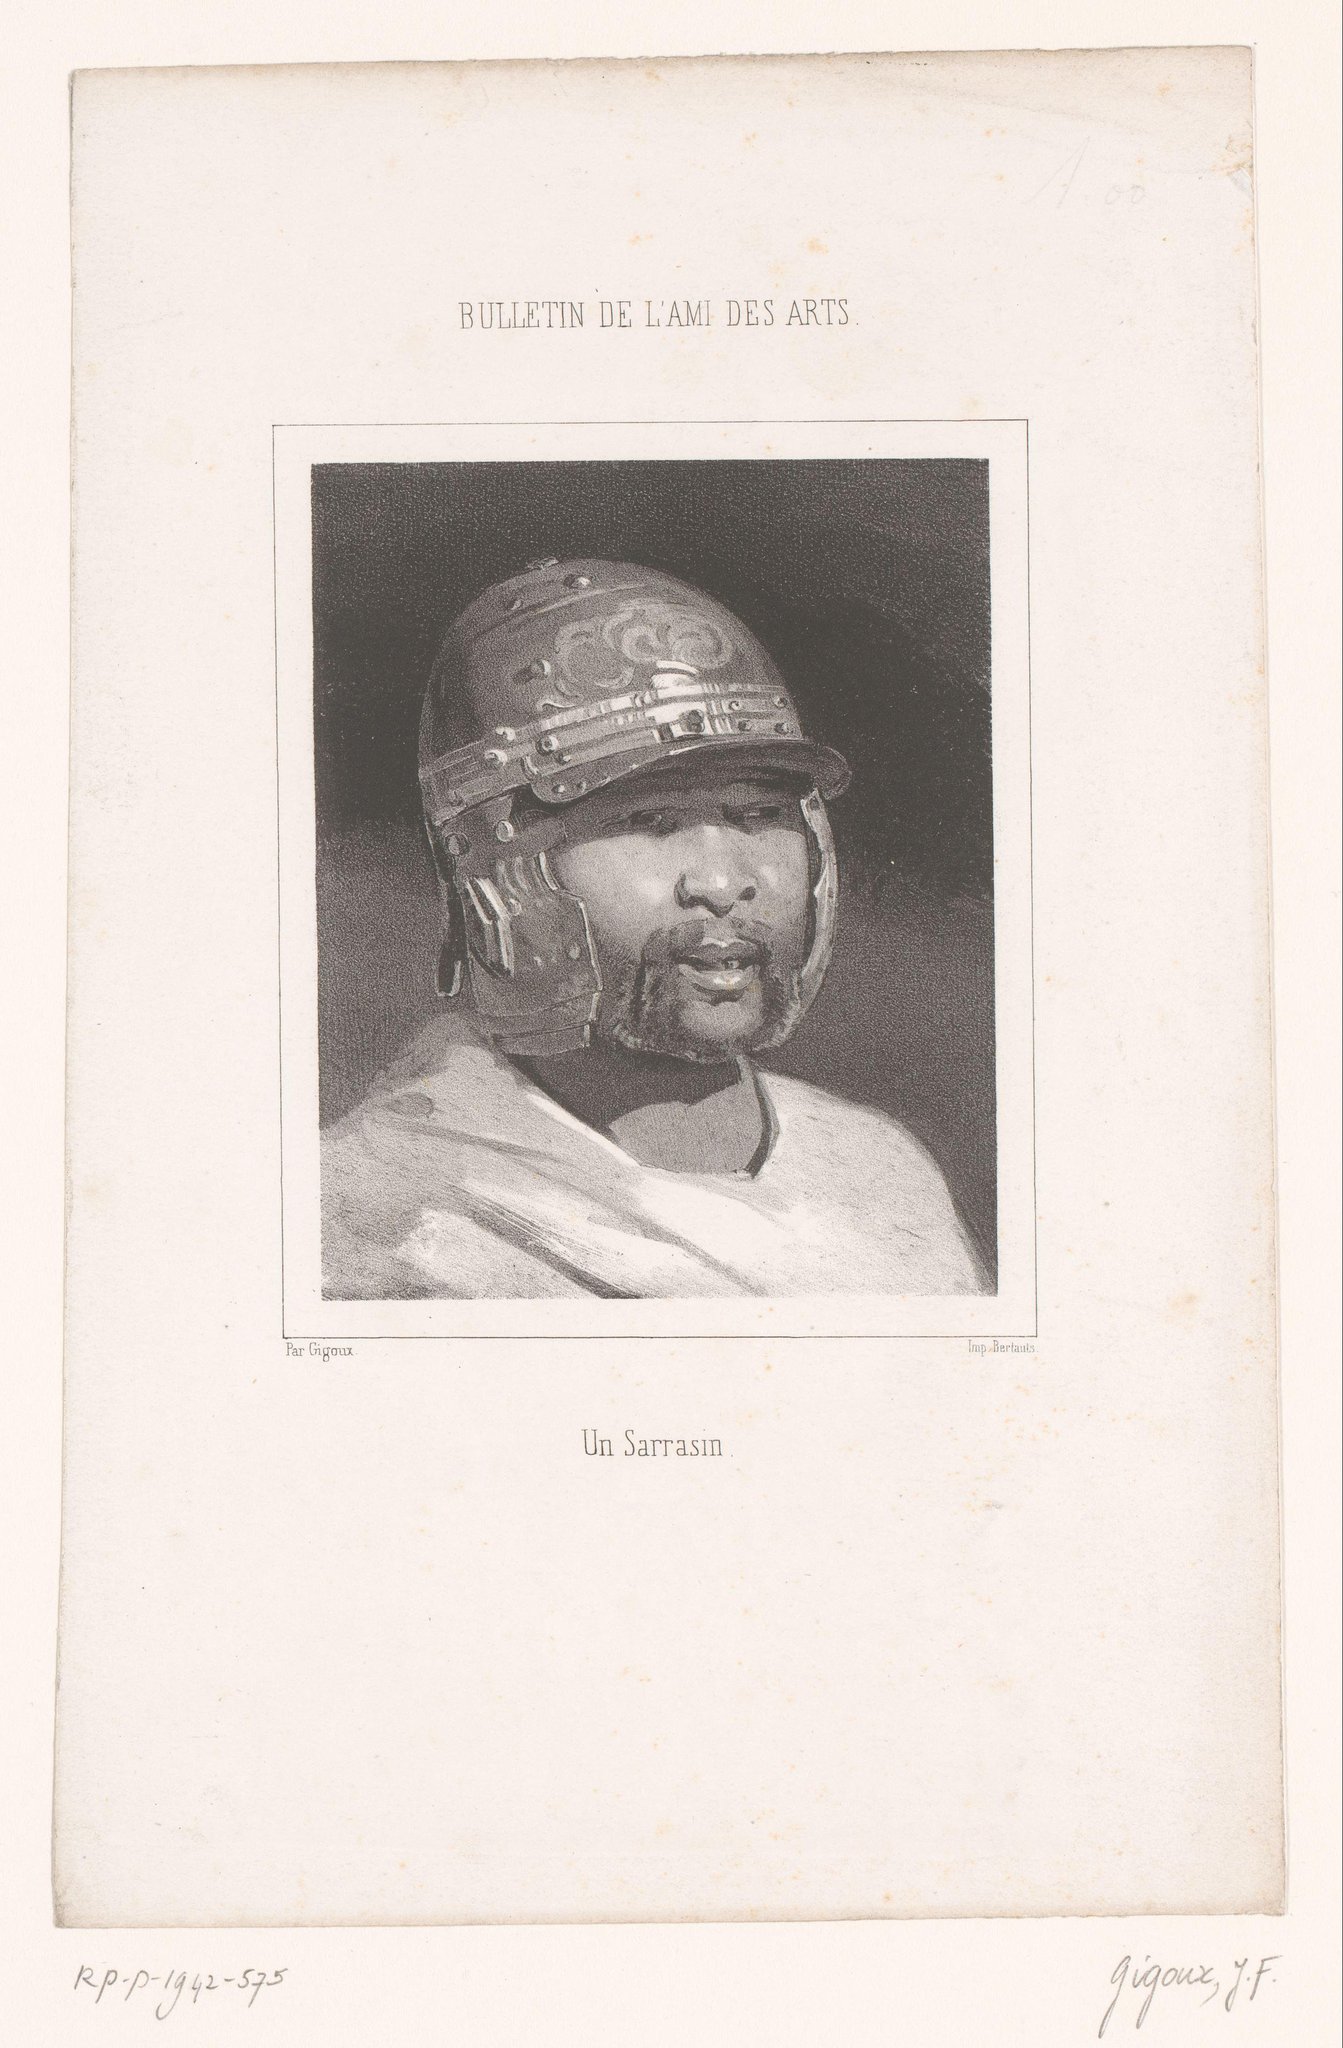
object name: print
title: Un Sarrasin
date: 1843-1845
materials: paper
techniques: lithograph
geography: paris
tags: helmet, private soldier, the believer ~ islam, mohammedanism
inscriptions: collector's mark: Lugt 2228a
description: Prent gebruikt voor: Bulletin de l'Ami des Arts, een tijdschrift dat werd gepubliceerd tussen 1843 en 1845.